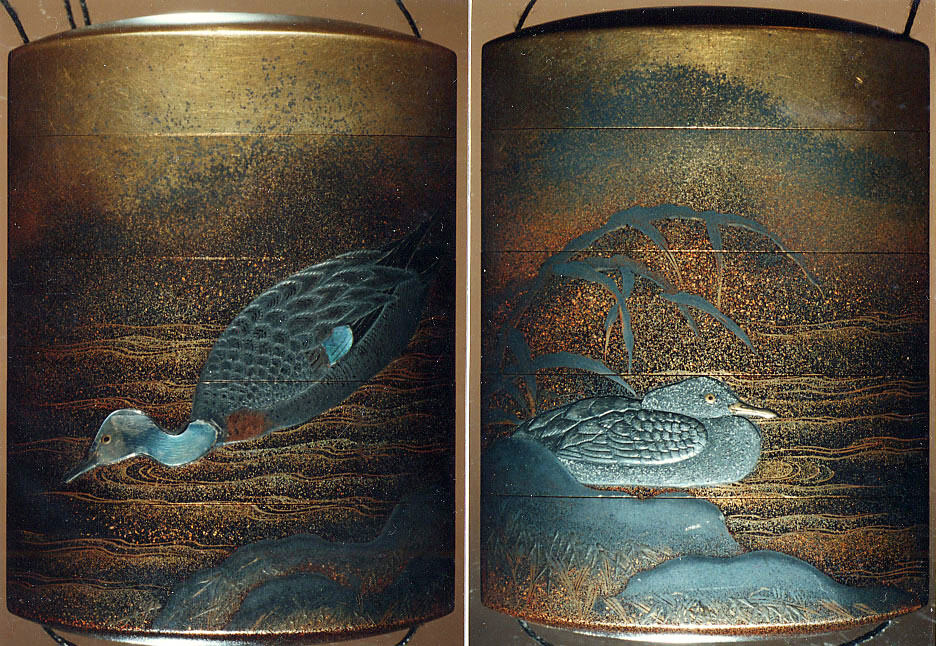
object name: inrō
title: Case (Inrō) with Design of Ducks beside Snow-Covered Reeds and Shore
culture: japanese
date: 1801-1900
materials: gold, lacquer, silver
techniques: fundame, hiramakie, inlay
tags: ducks